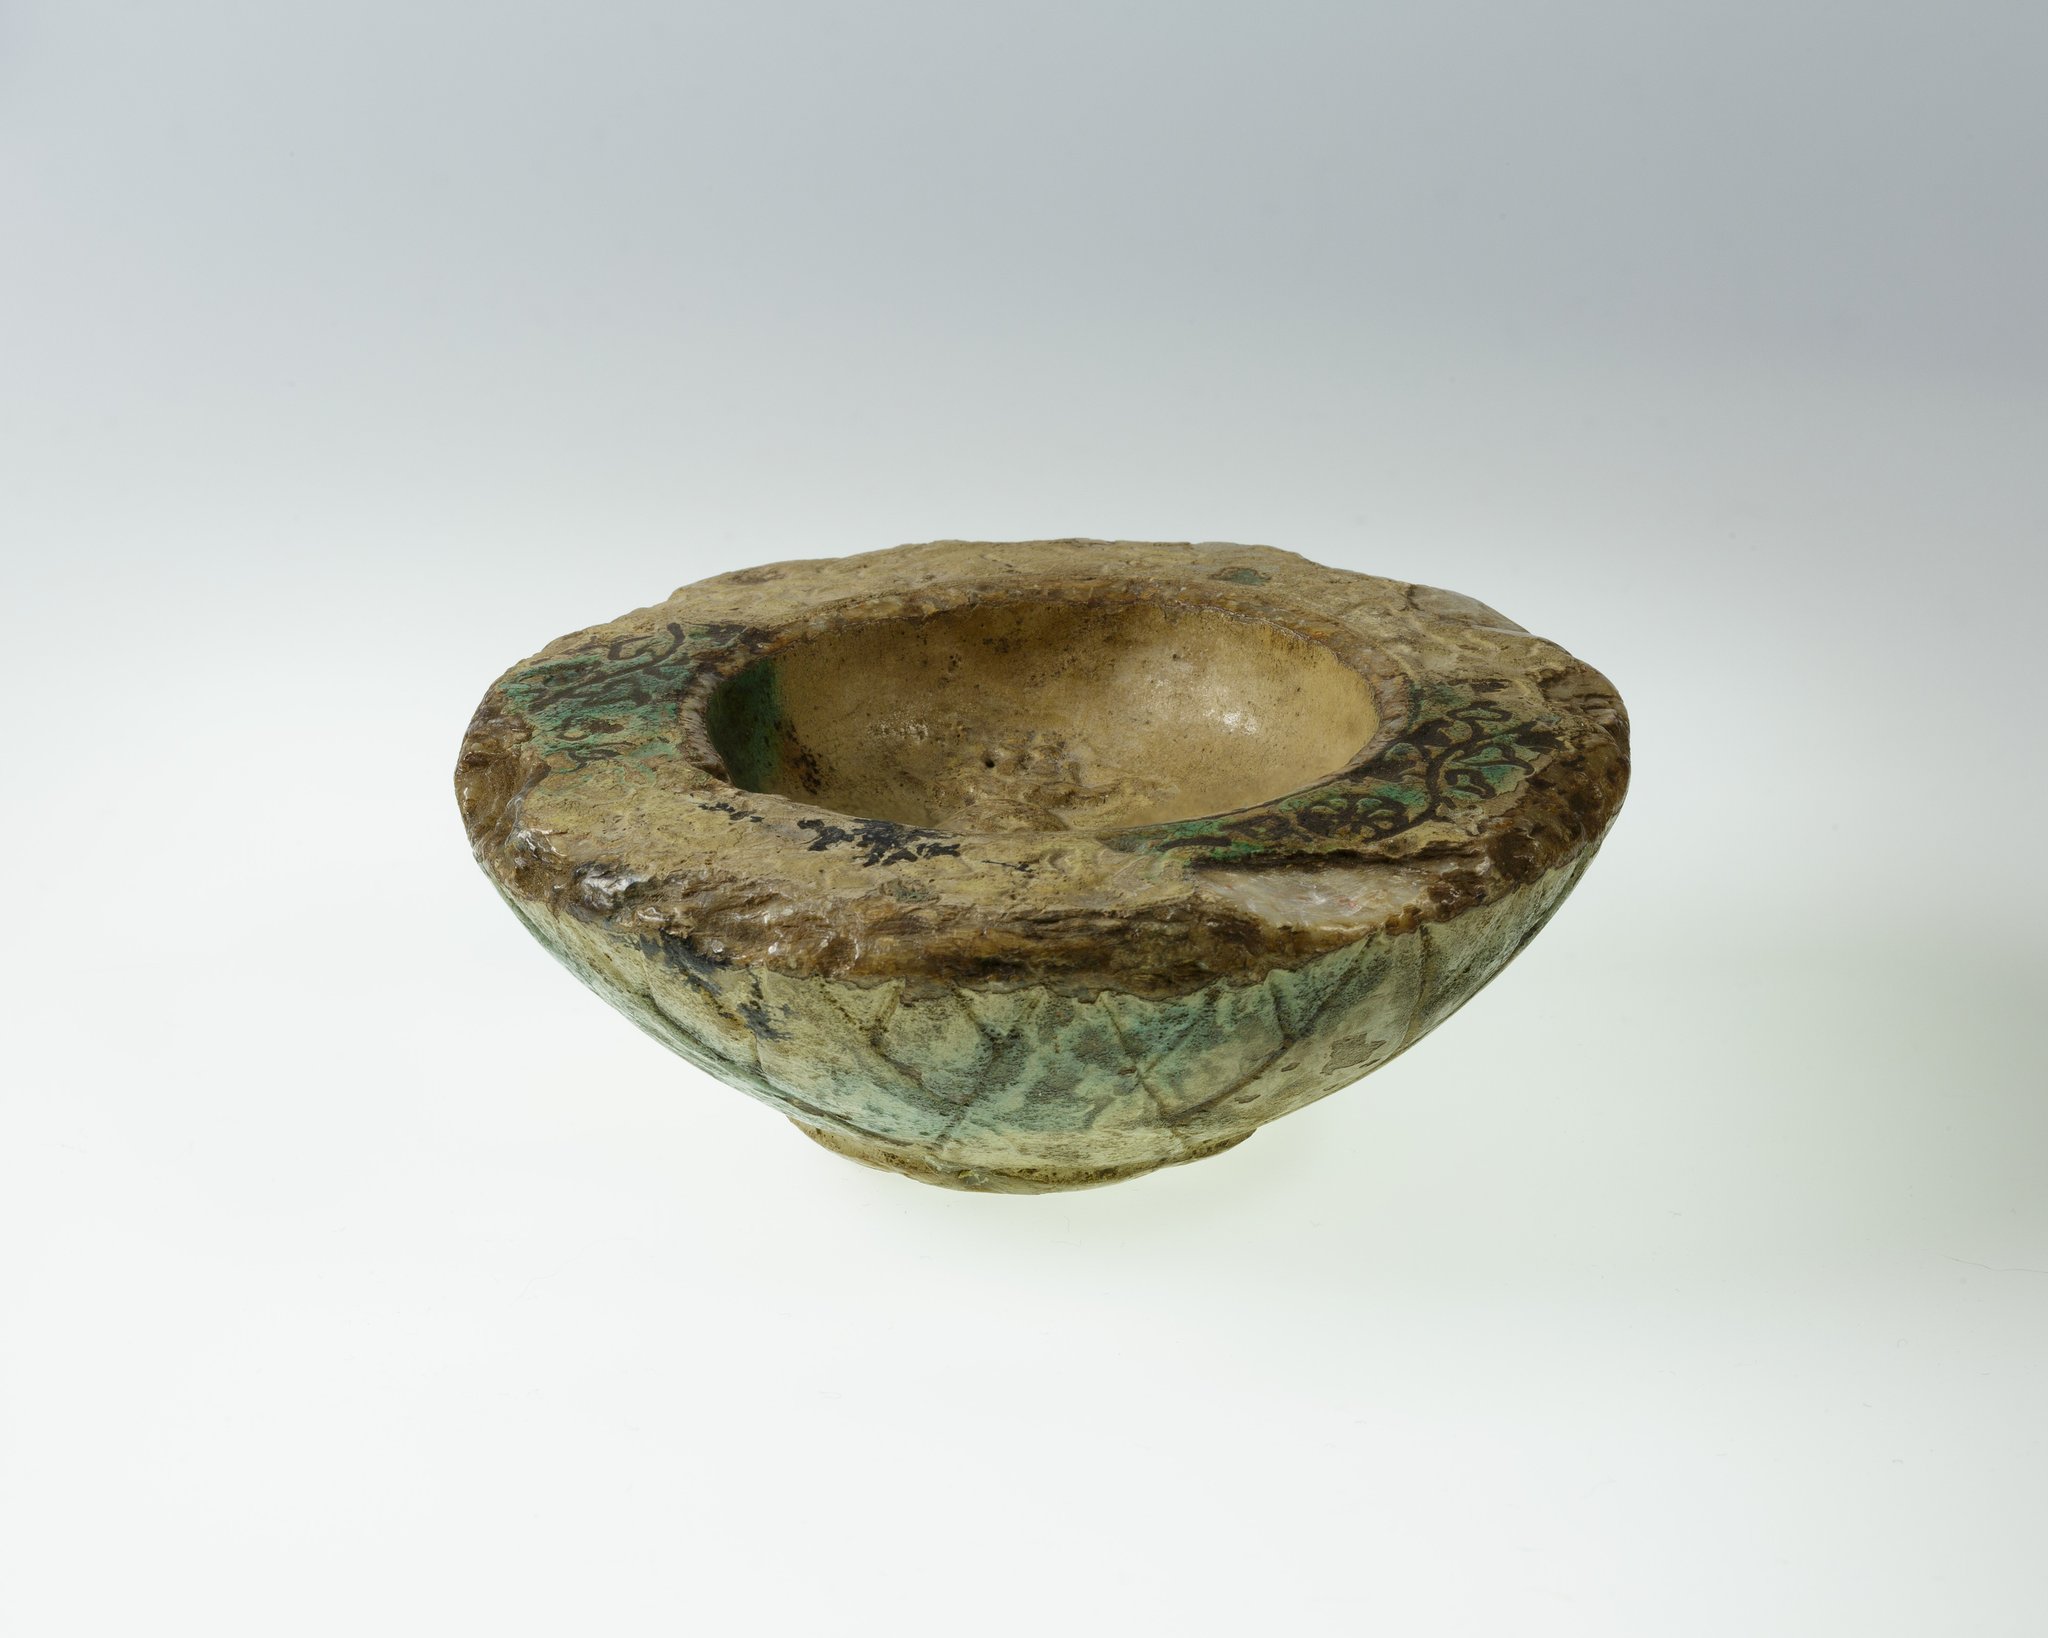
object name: bowl, lotus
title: Lotus bowl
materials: stone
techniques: glazing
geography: egypt